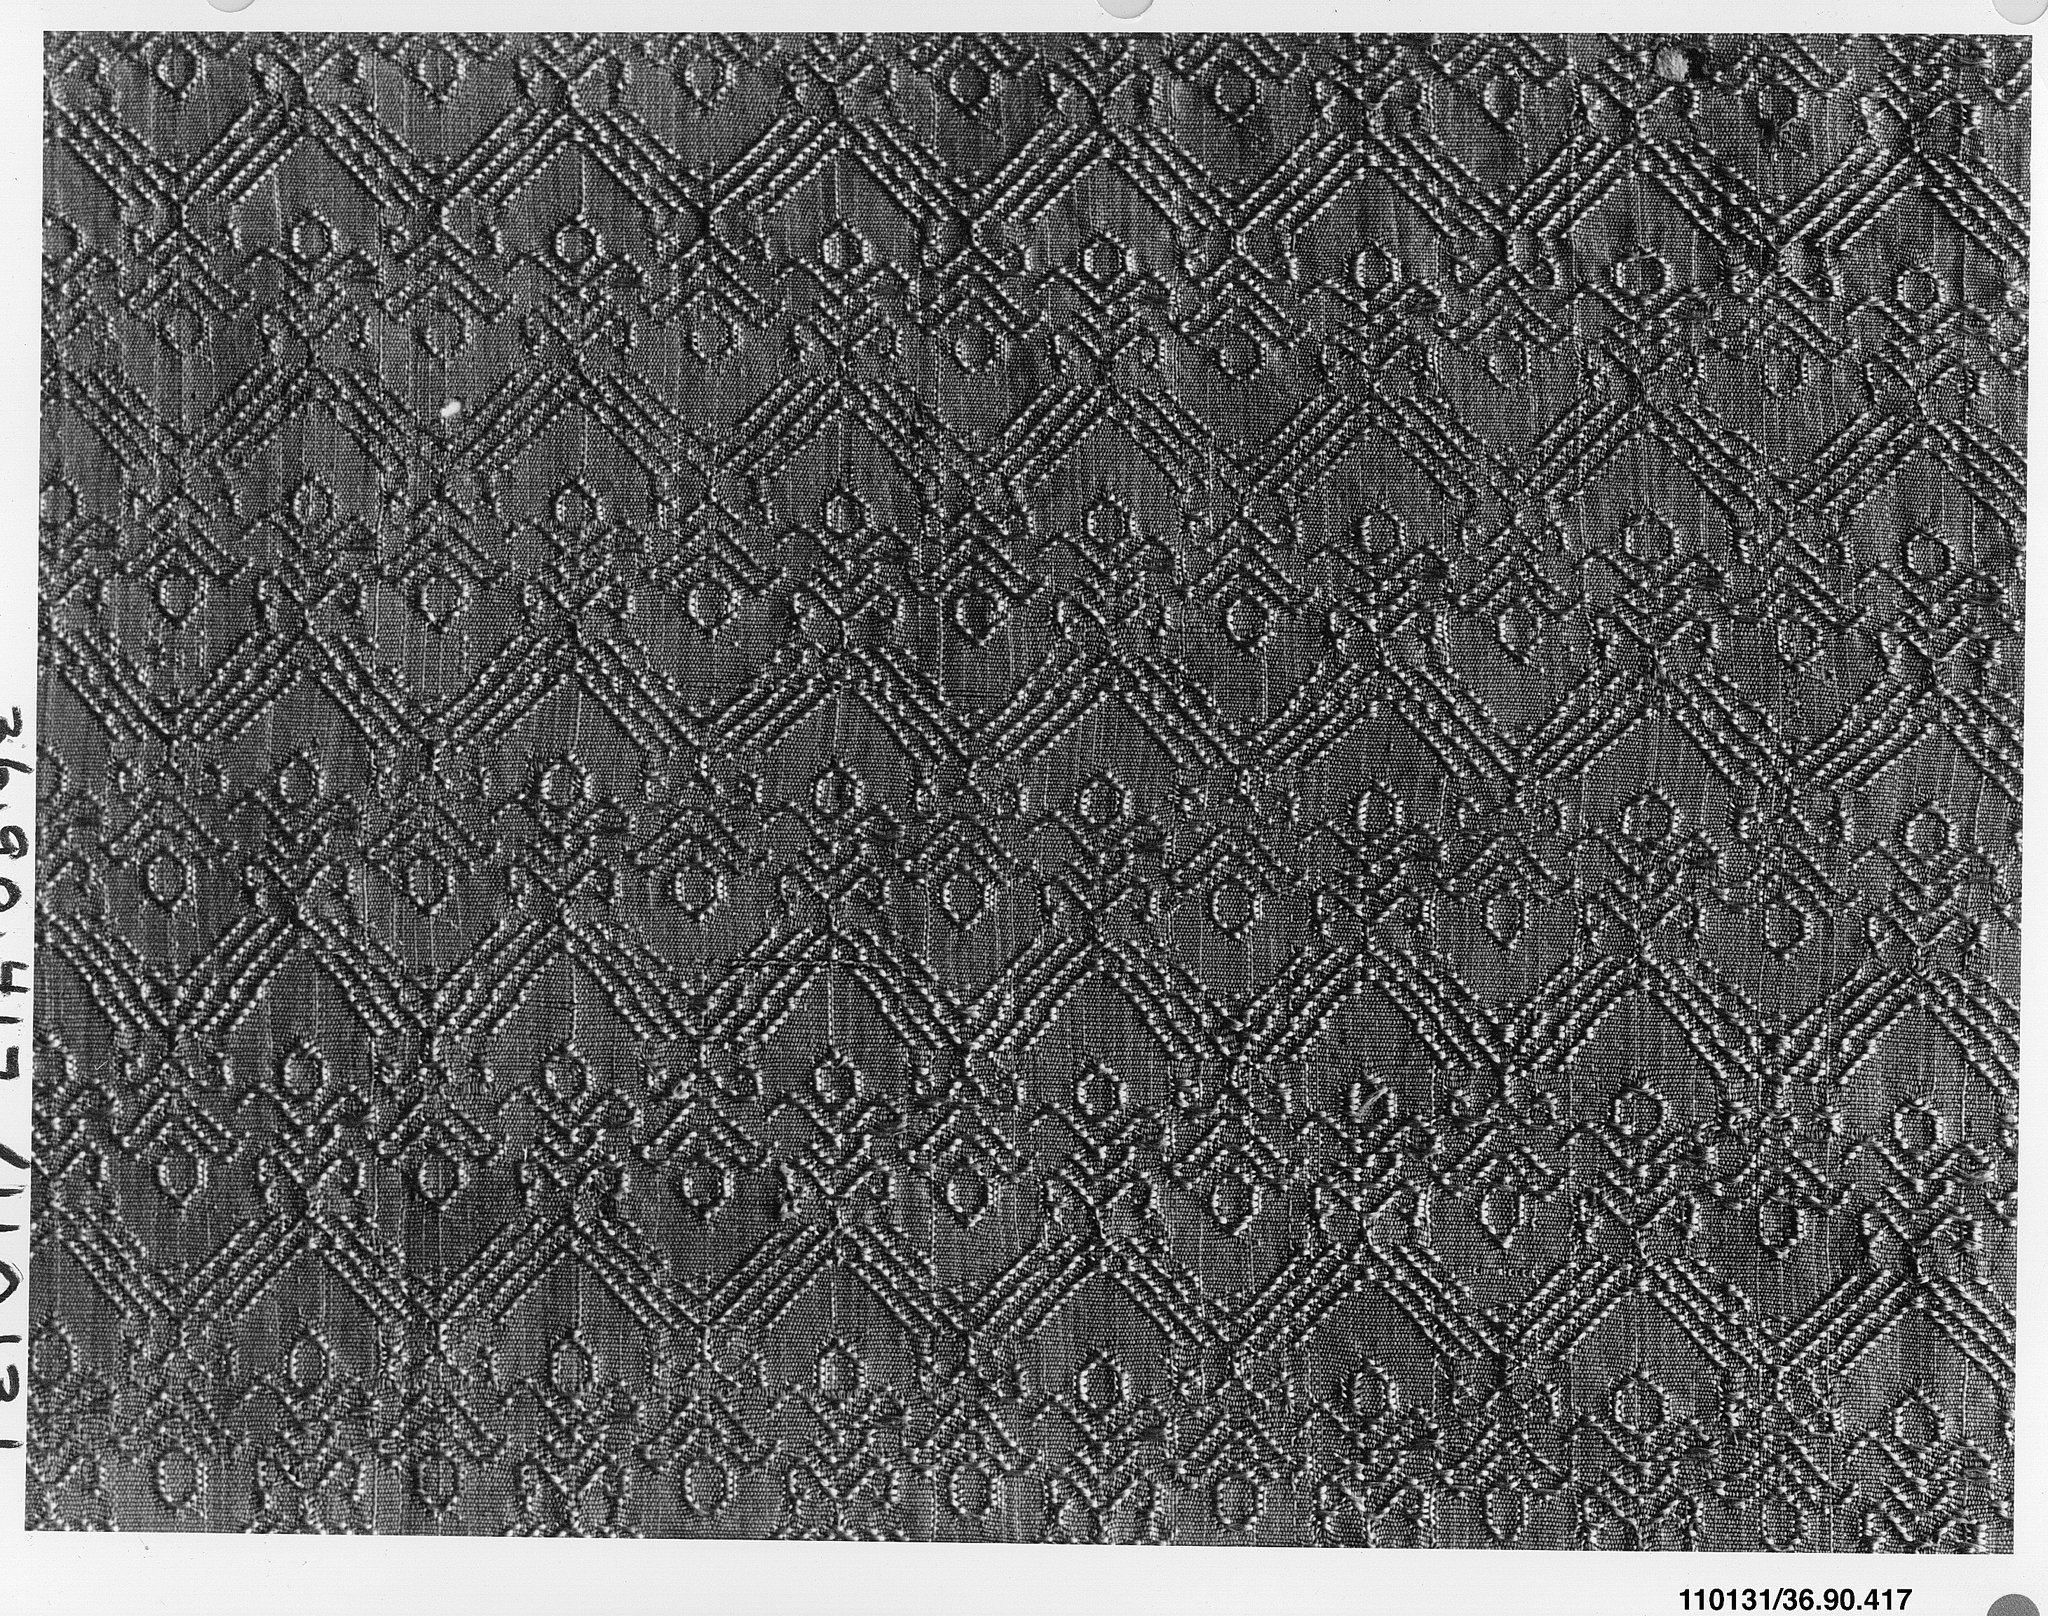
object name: piece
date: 1501-1700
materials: metal thread, silk